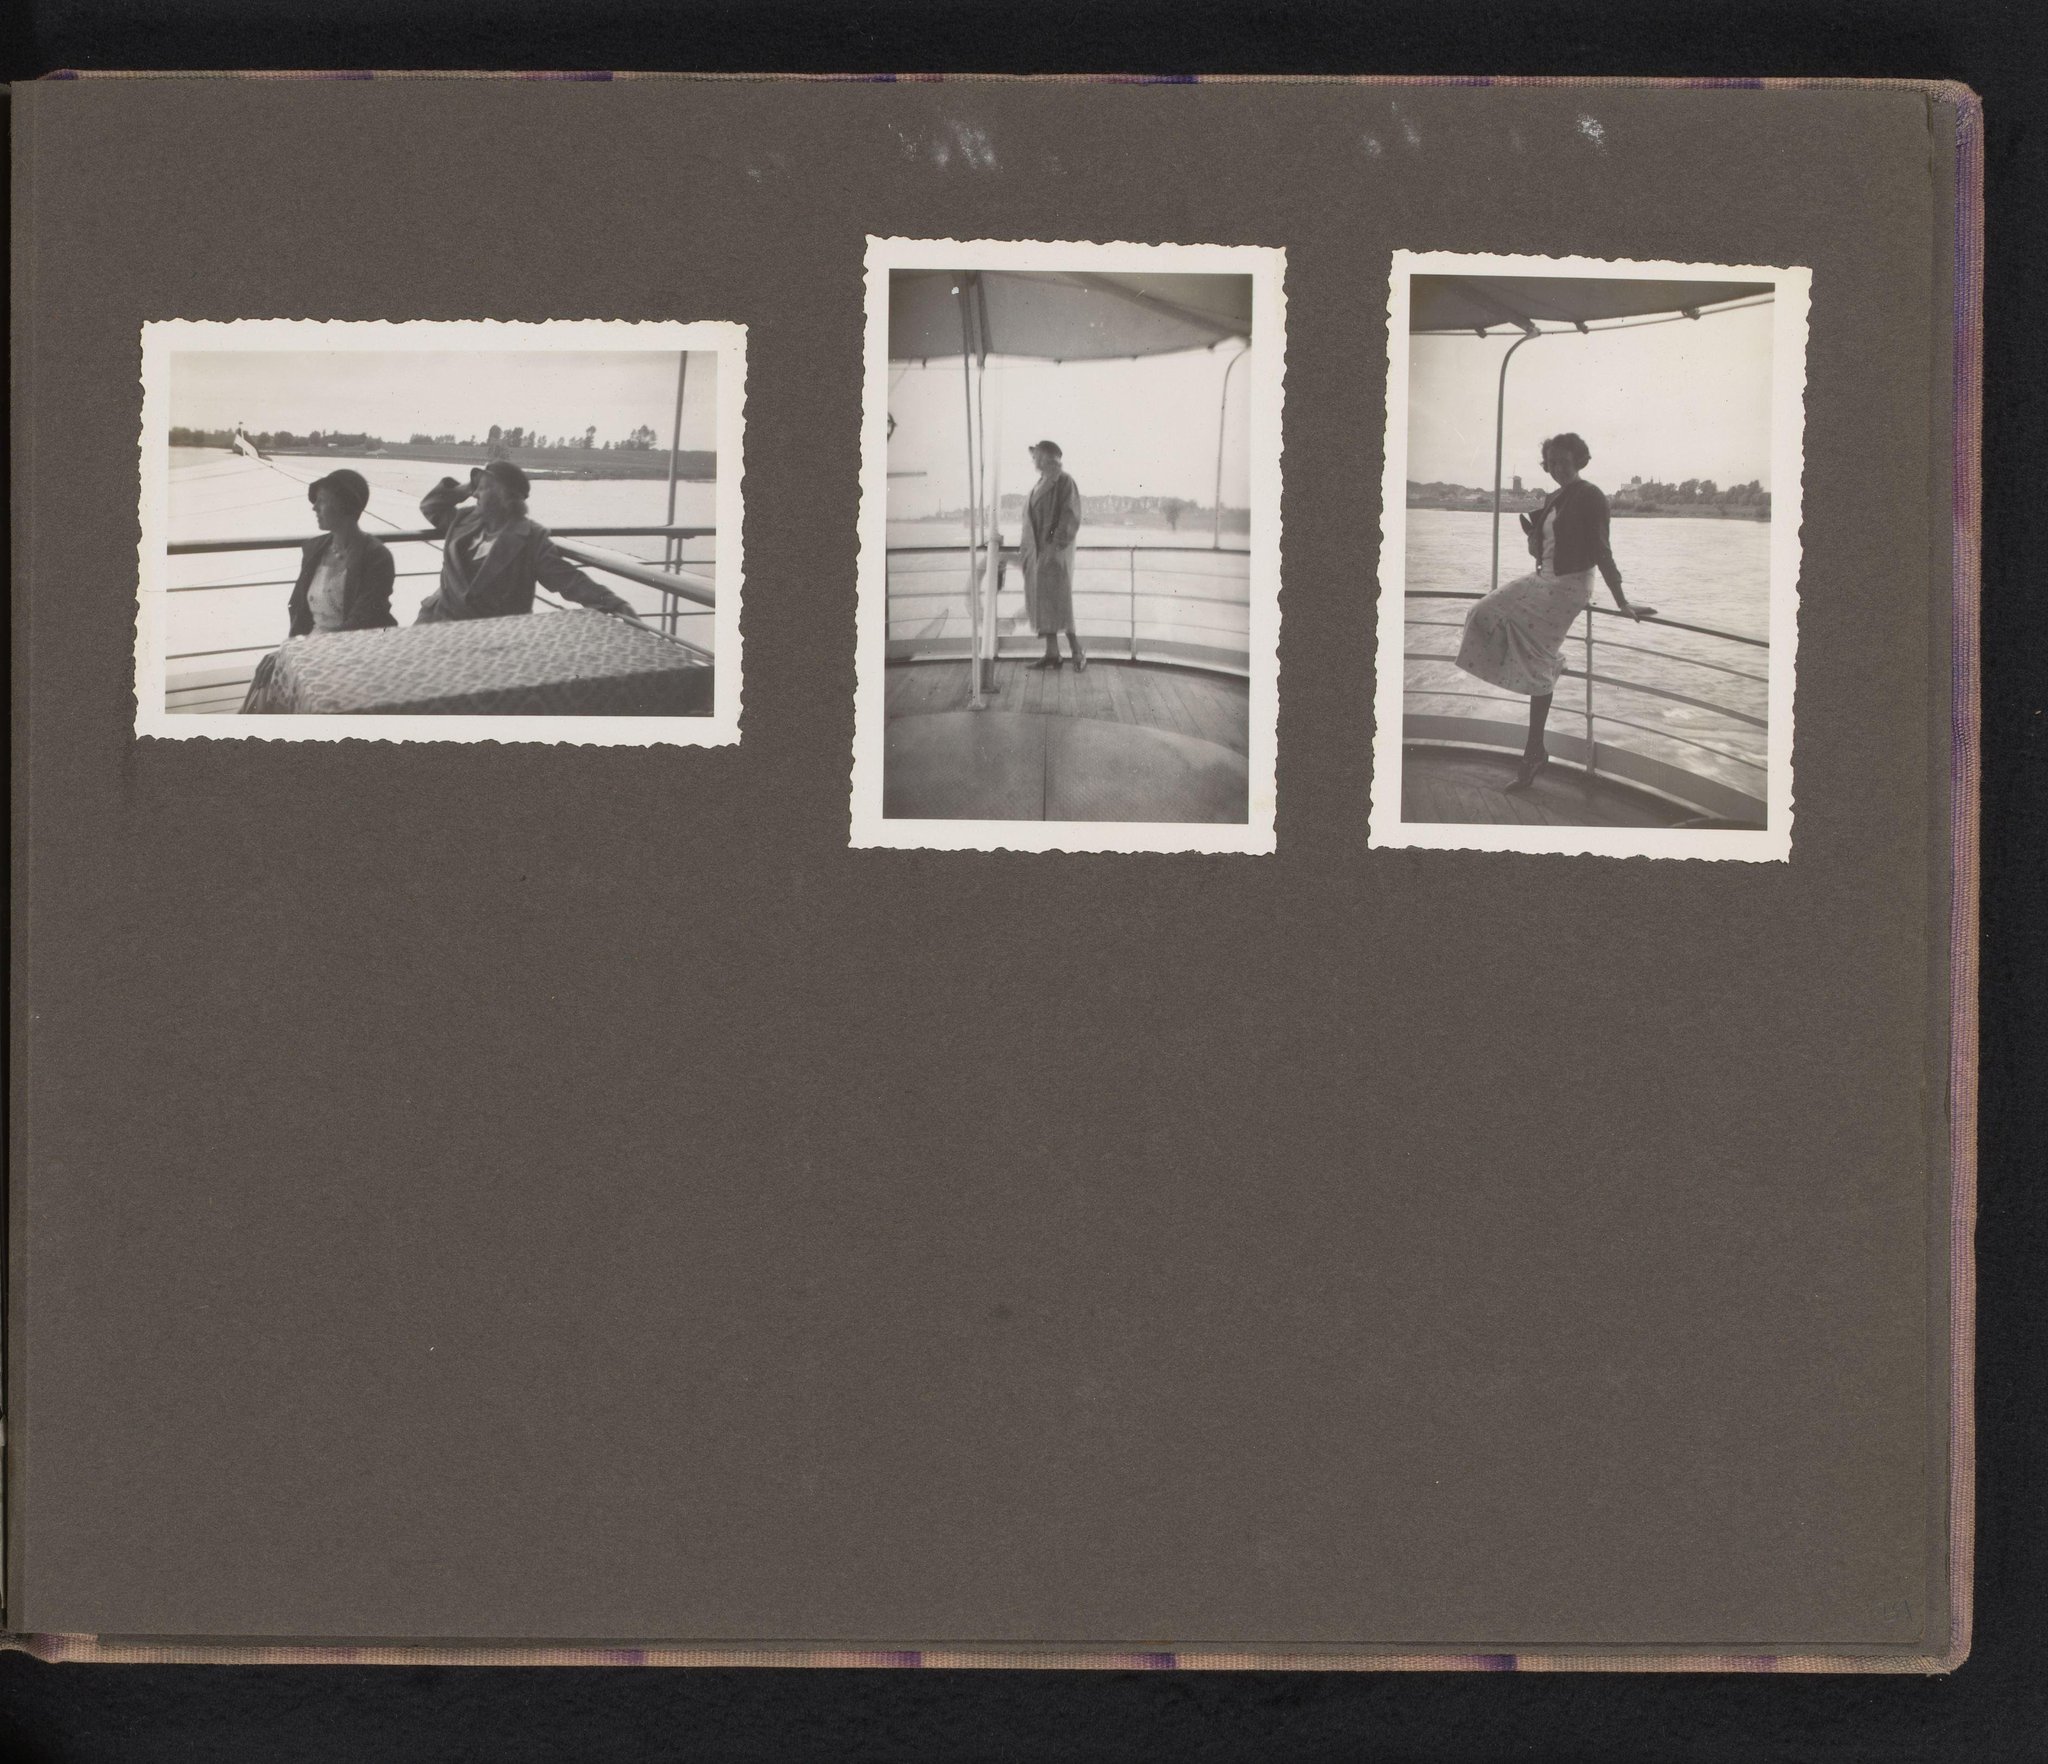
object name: album leaf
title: Berti Hoppe en haar moeder op de boot van Arnhem naar Nijmegen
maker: herman besselaar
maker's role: taalkundige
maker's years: 1904-1994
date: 1933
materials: cardboard, paper, photographic support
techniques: gelatin silver print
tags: landscapes with waters, waterscapes, seascapes (in the temperate zone), mother and daughter(s) (family group), steamship, motorship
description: Drie foto's gemaakt tijdens het bezoek van Berti Hoppe's moeder in de zomer van 1933. Deze pagina maakt deel uit van een album.